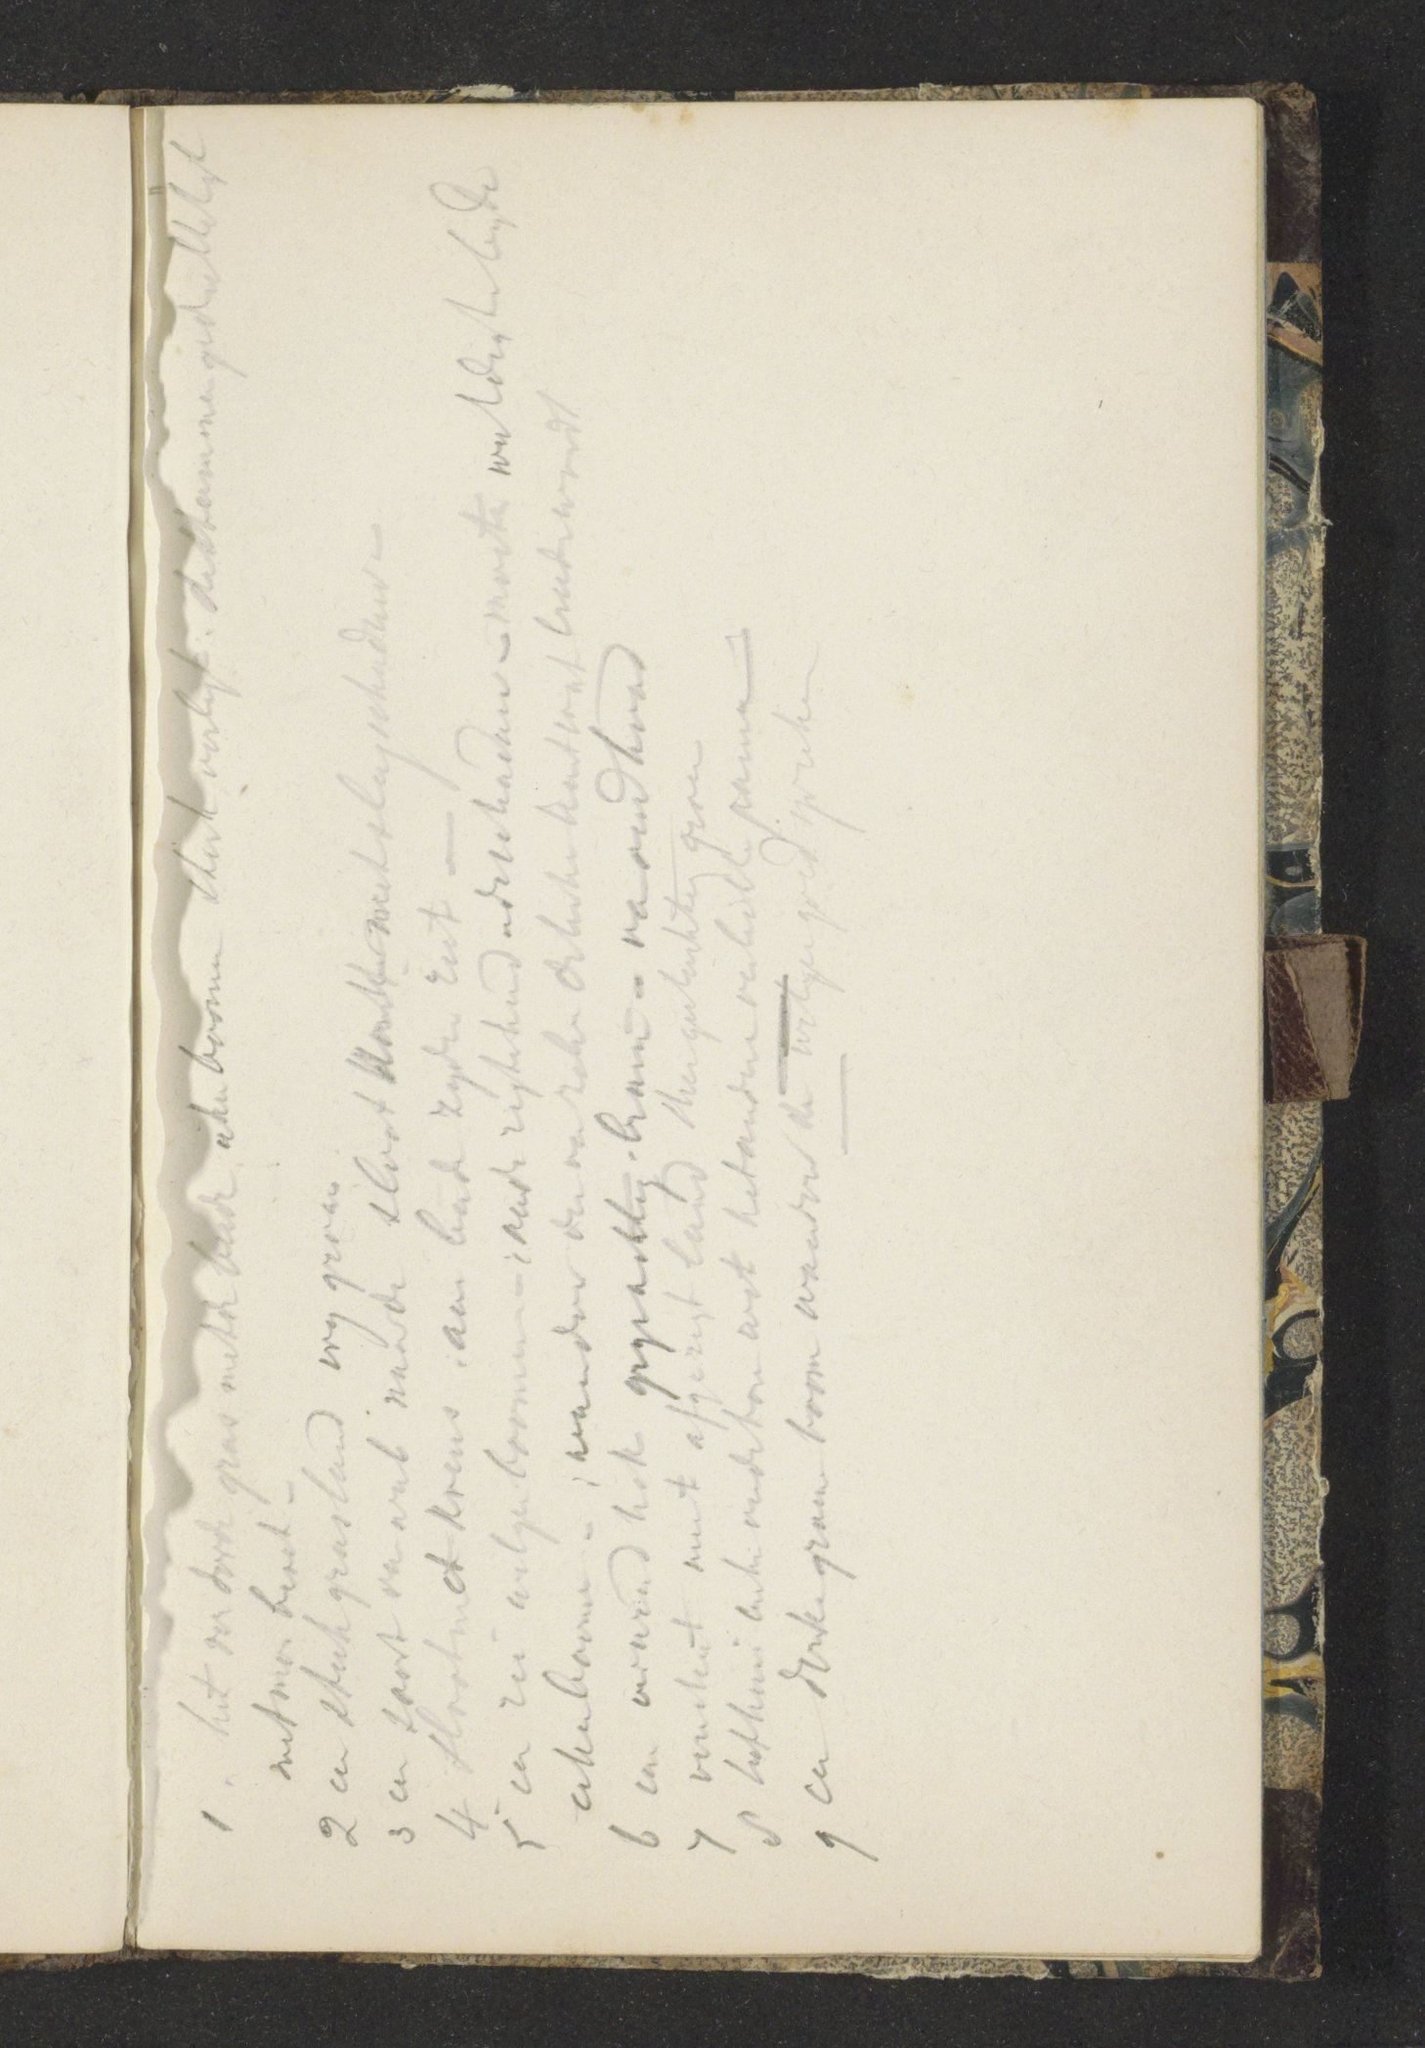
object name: sketchbook leaf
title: Beschrijving van een landschap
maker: Anonymous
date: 1802-1874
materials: paper, pencil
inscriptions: annotation: ‘1. het verdorde gras ... wilgen goed [...]reken’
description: Blad 13 recto uit een schetsboek met 19 bladen.